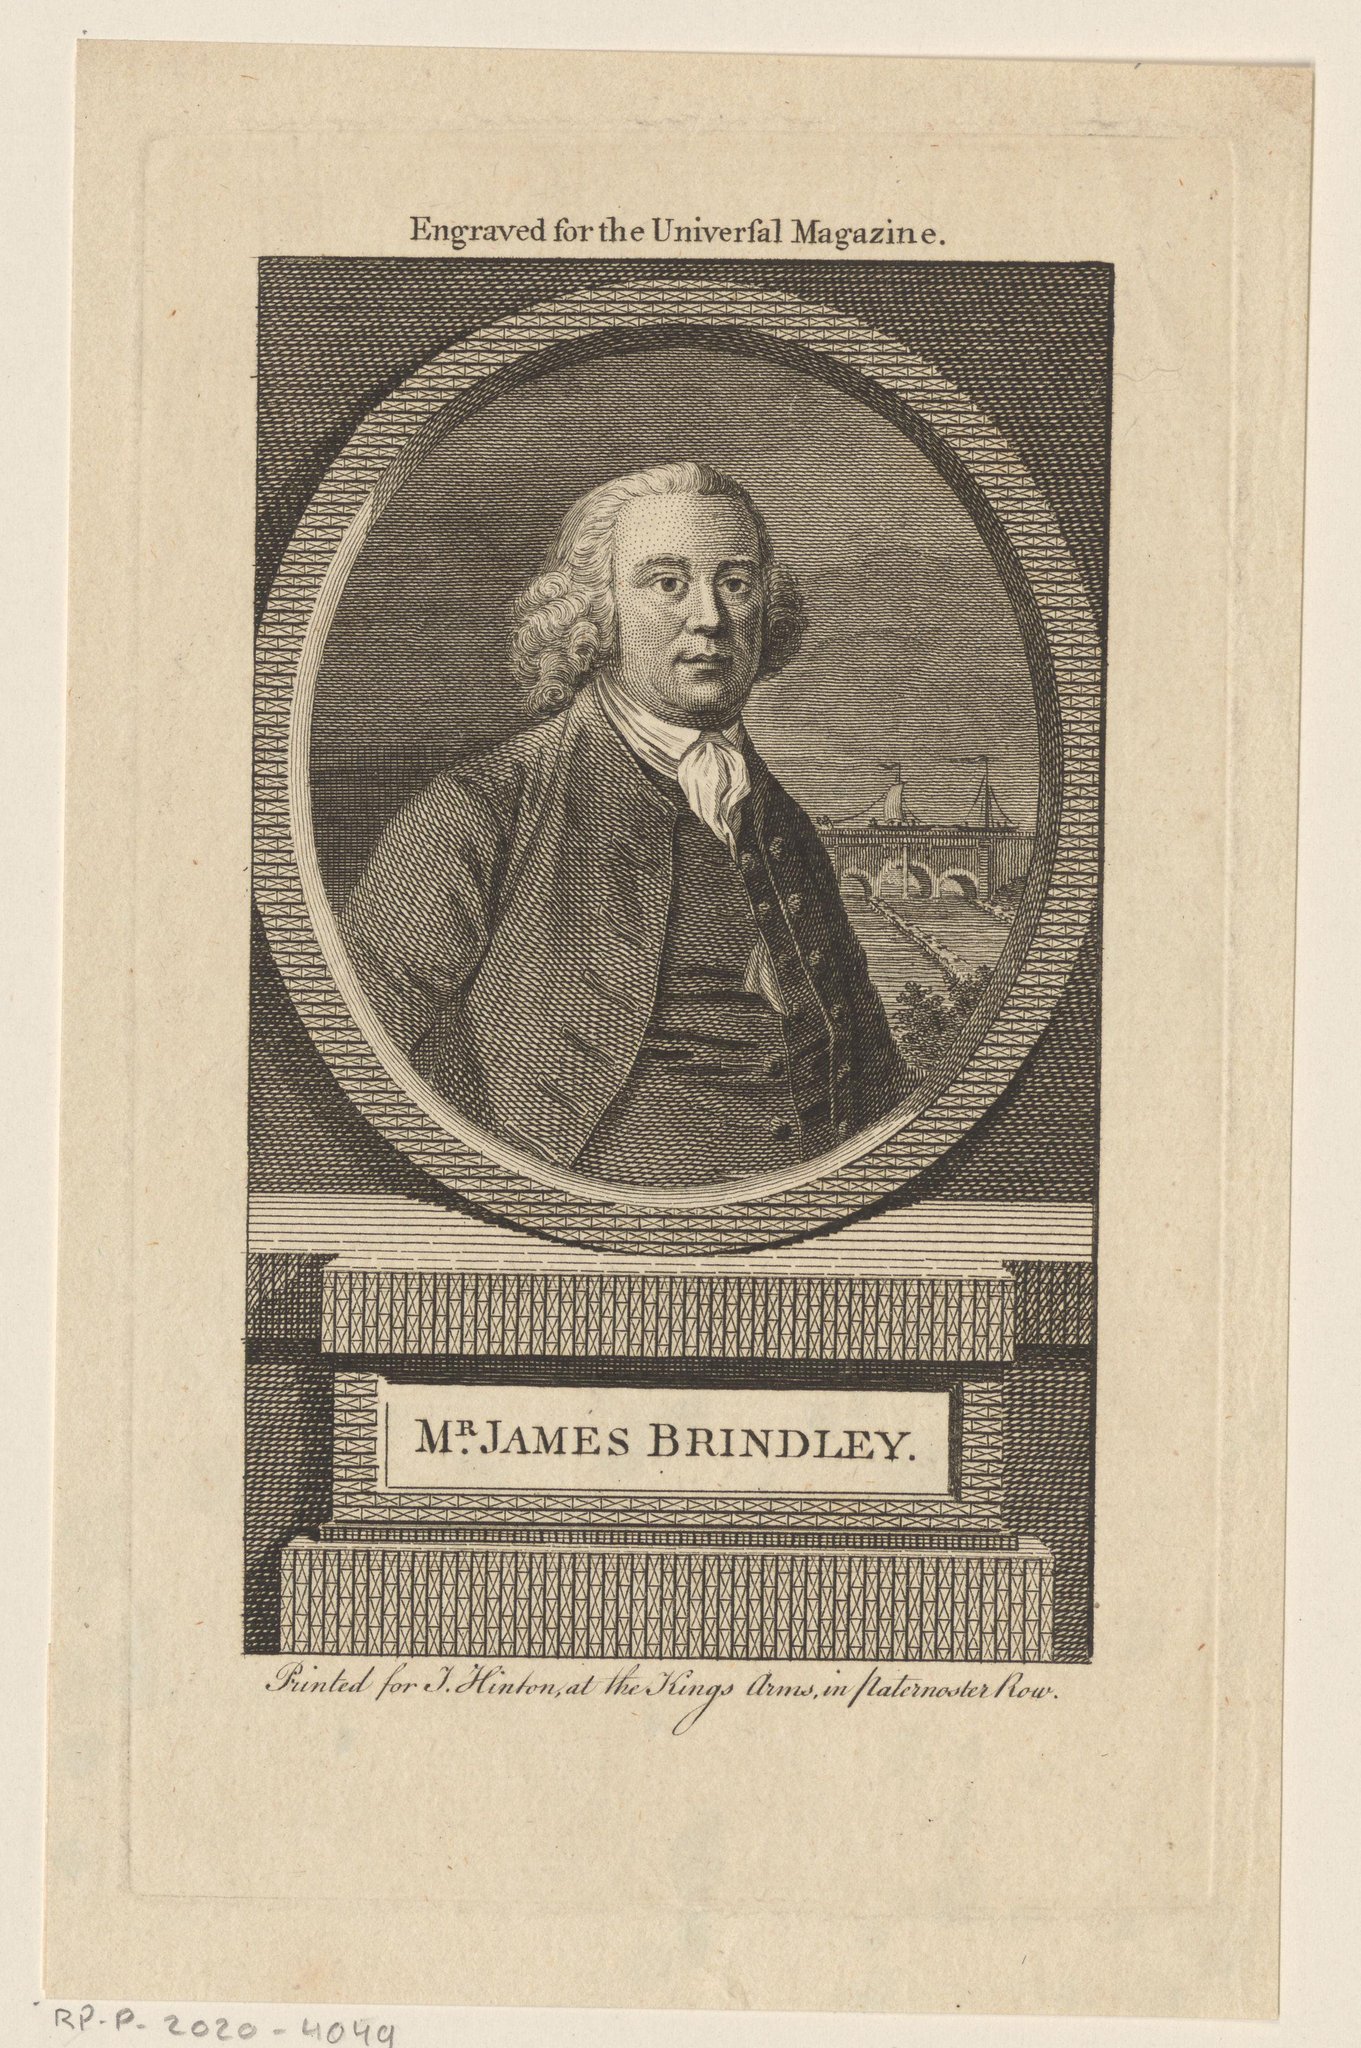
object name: print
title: Portret van James Brindley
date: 1747-1781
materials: paper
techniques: engraving, etching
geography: london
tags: historical persons, aqueduct (~ water supply)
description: Prent uit: The Universal Magazine of Knowledge and Pleasure, 1747-1781.